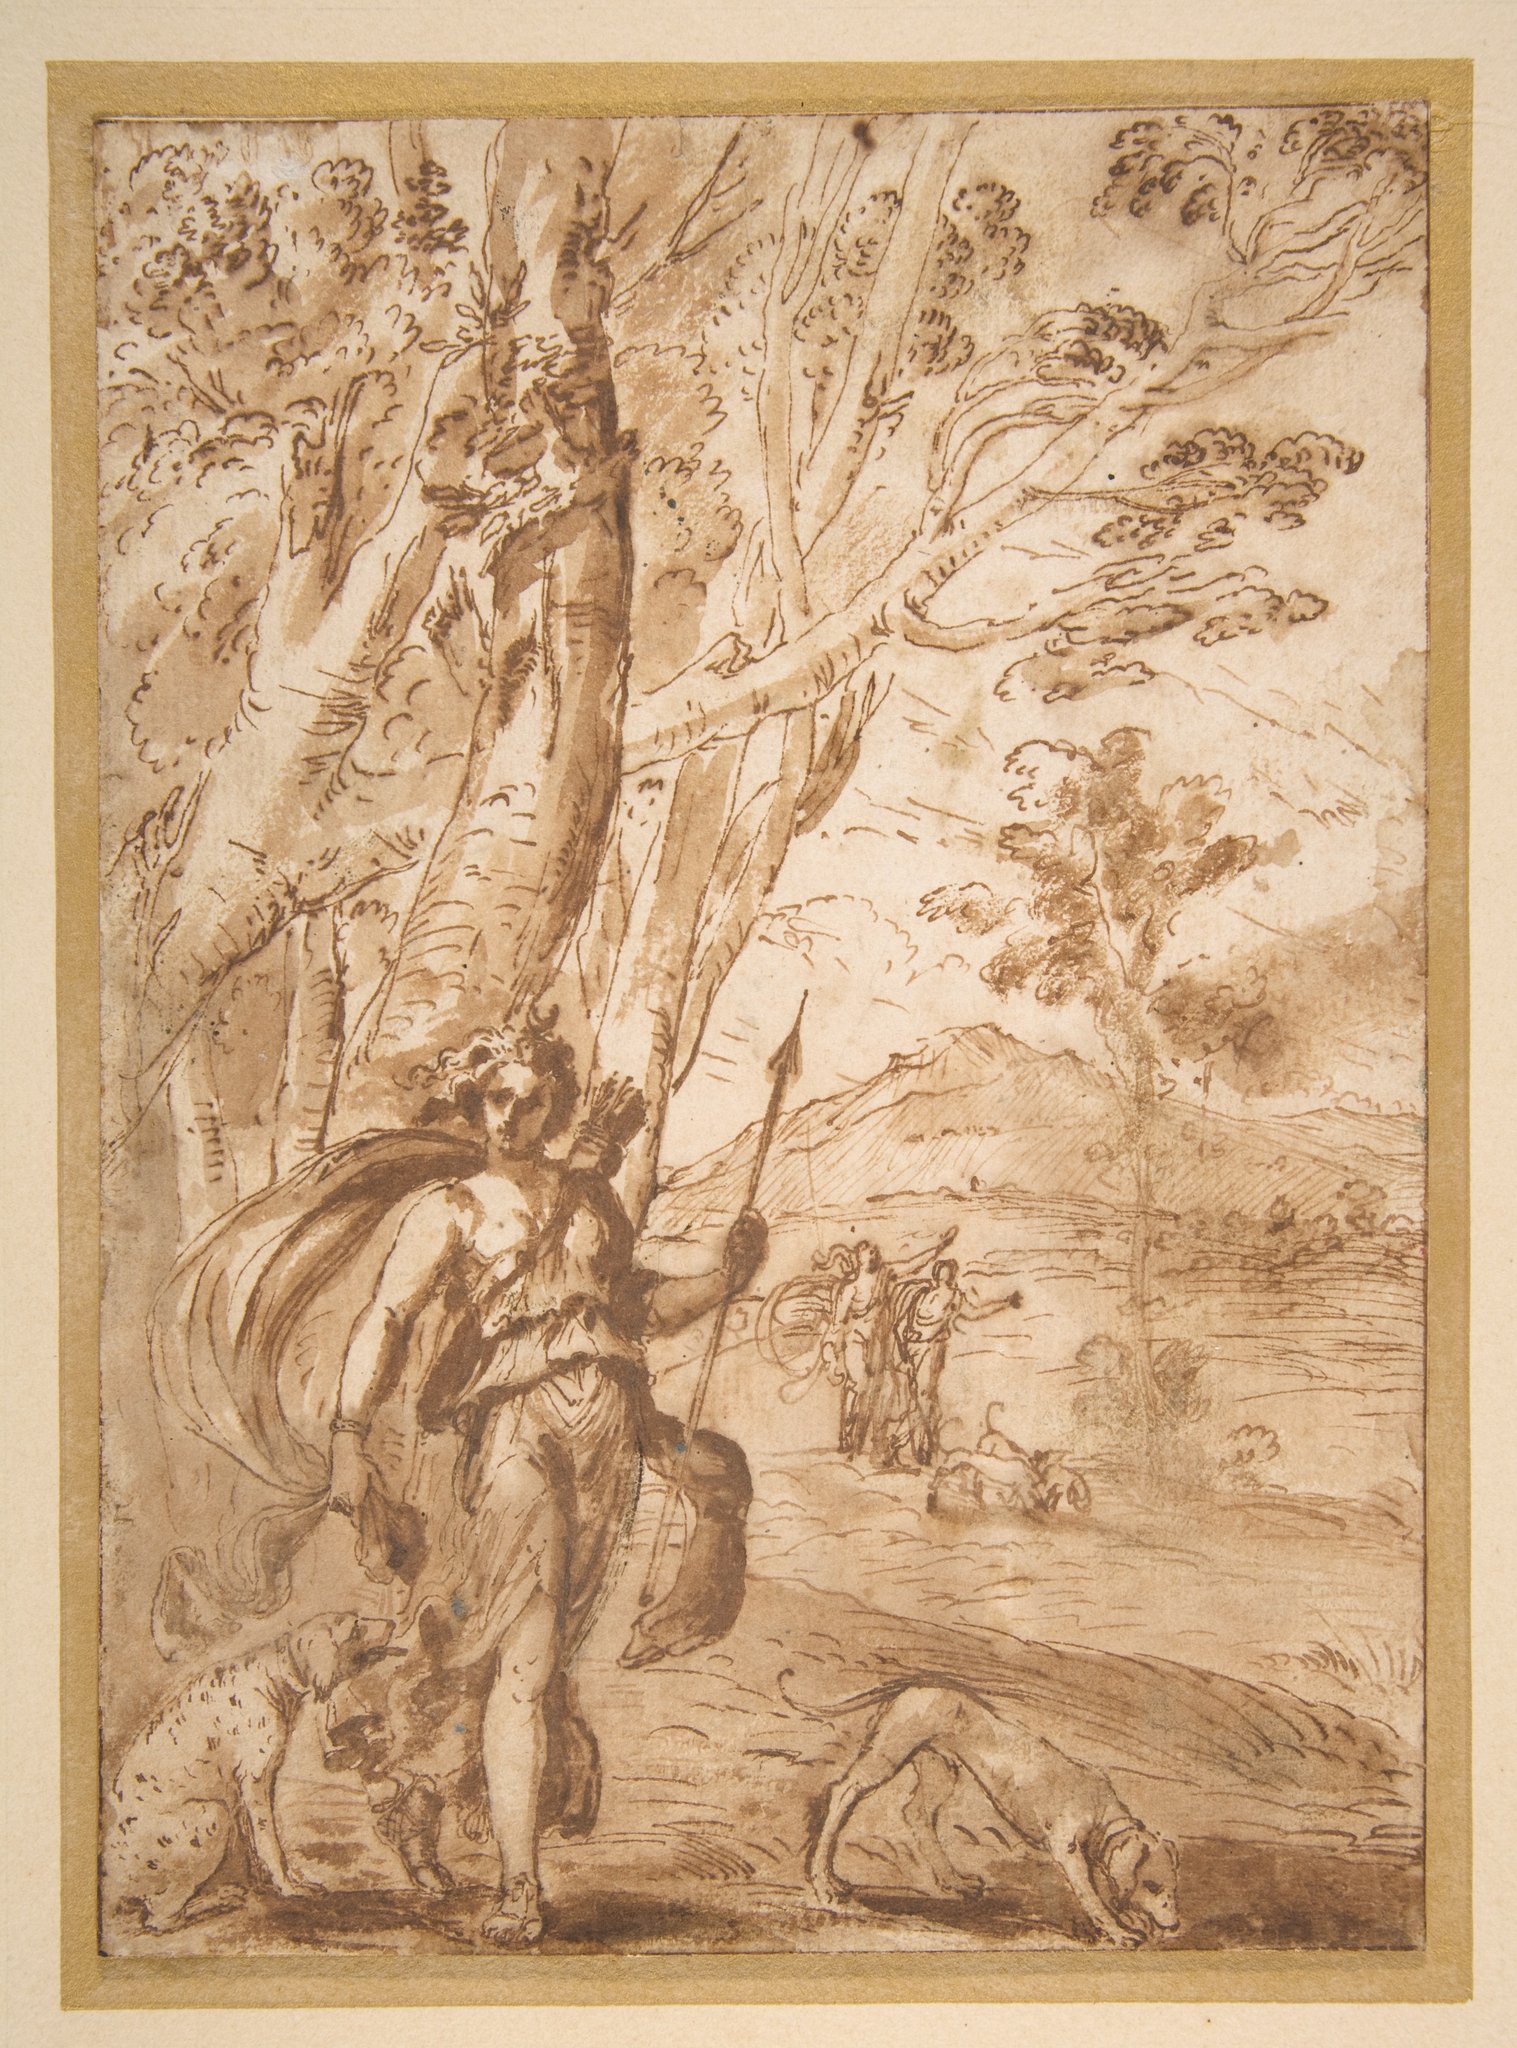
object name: drawing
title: The Goddess Diana with Her Hounds Standing in a Landscape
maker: agostino tassi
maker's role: artist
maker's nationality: italian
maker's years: 1580-1644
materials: ink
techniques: brush, pen, wash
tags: men,diana,dogs,landscapes